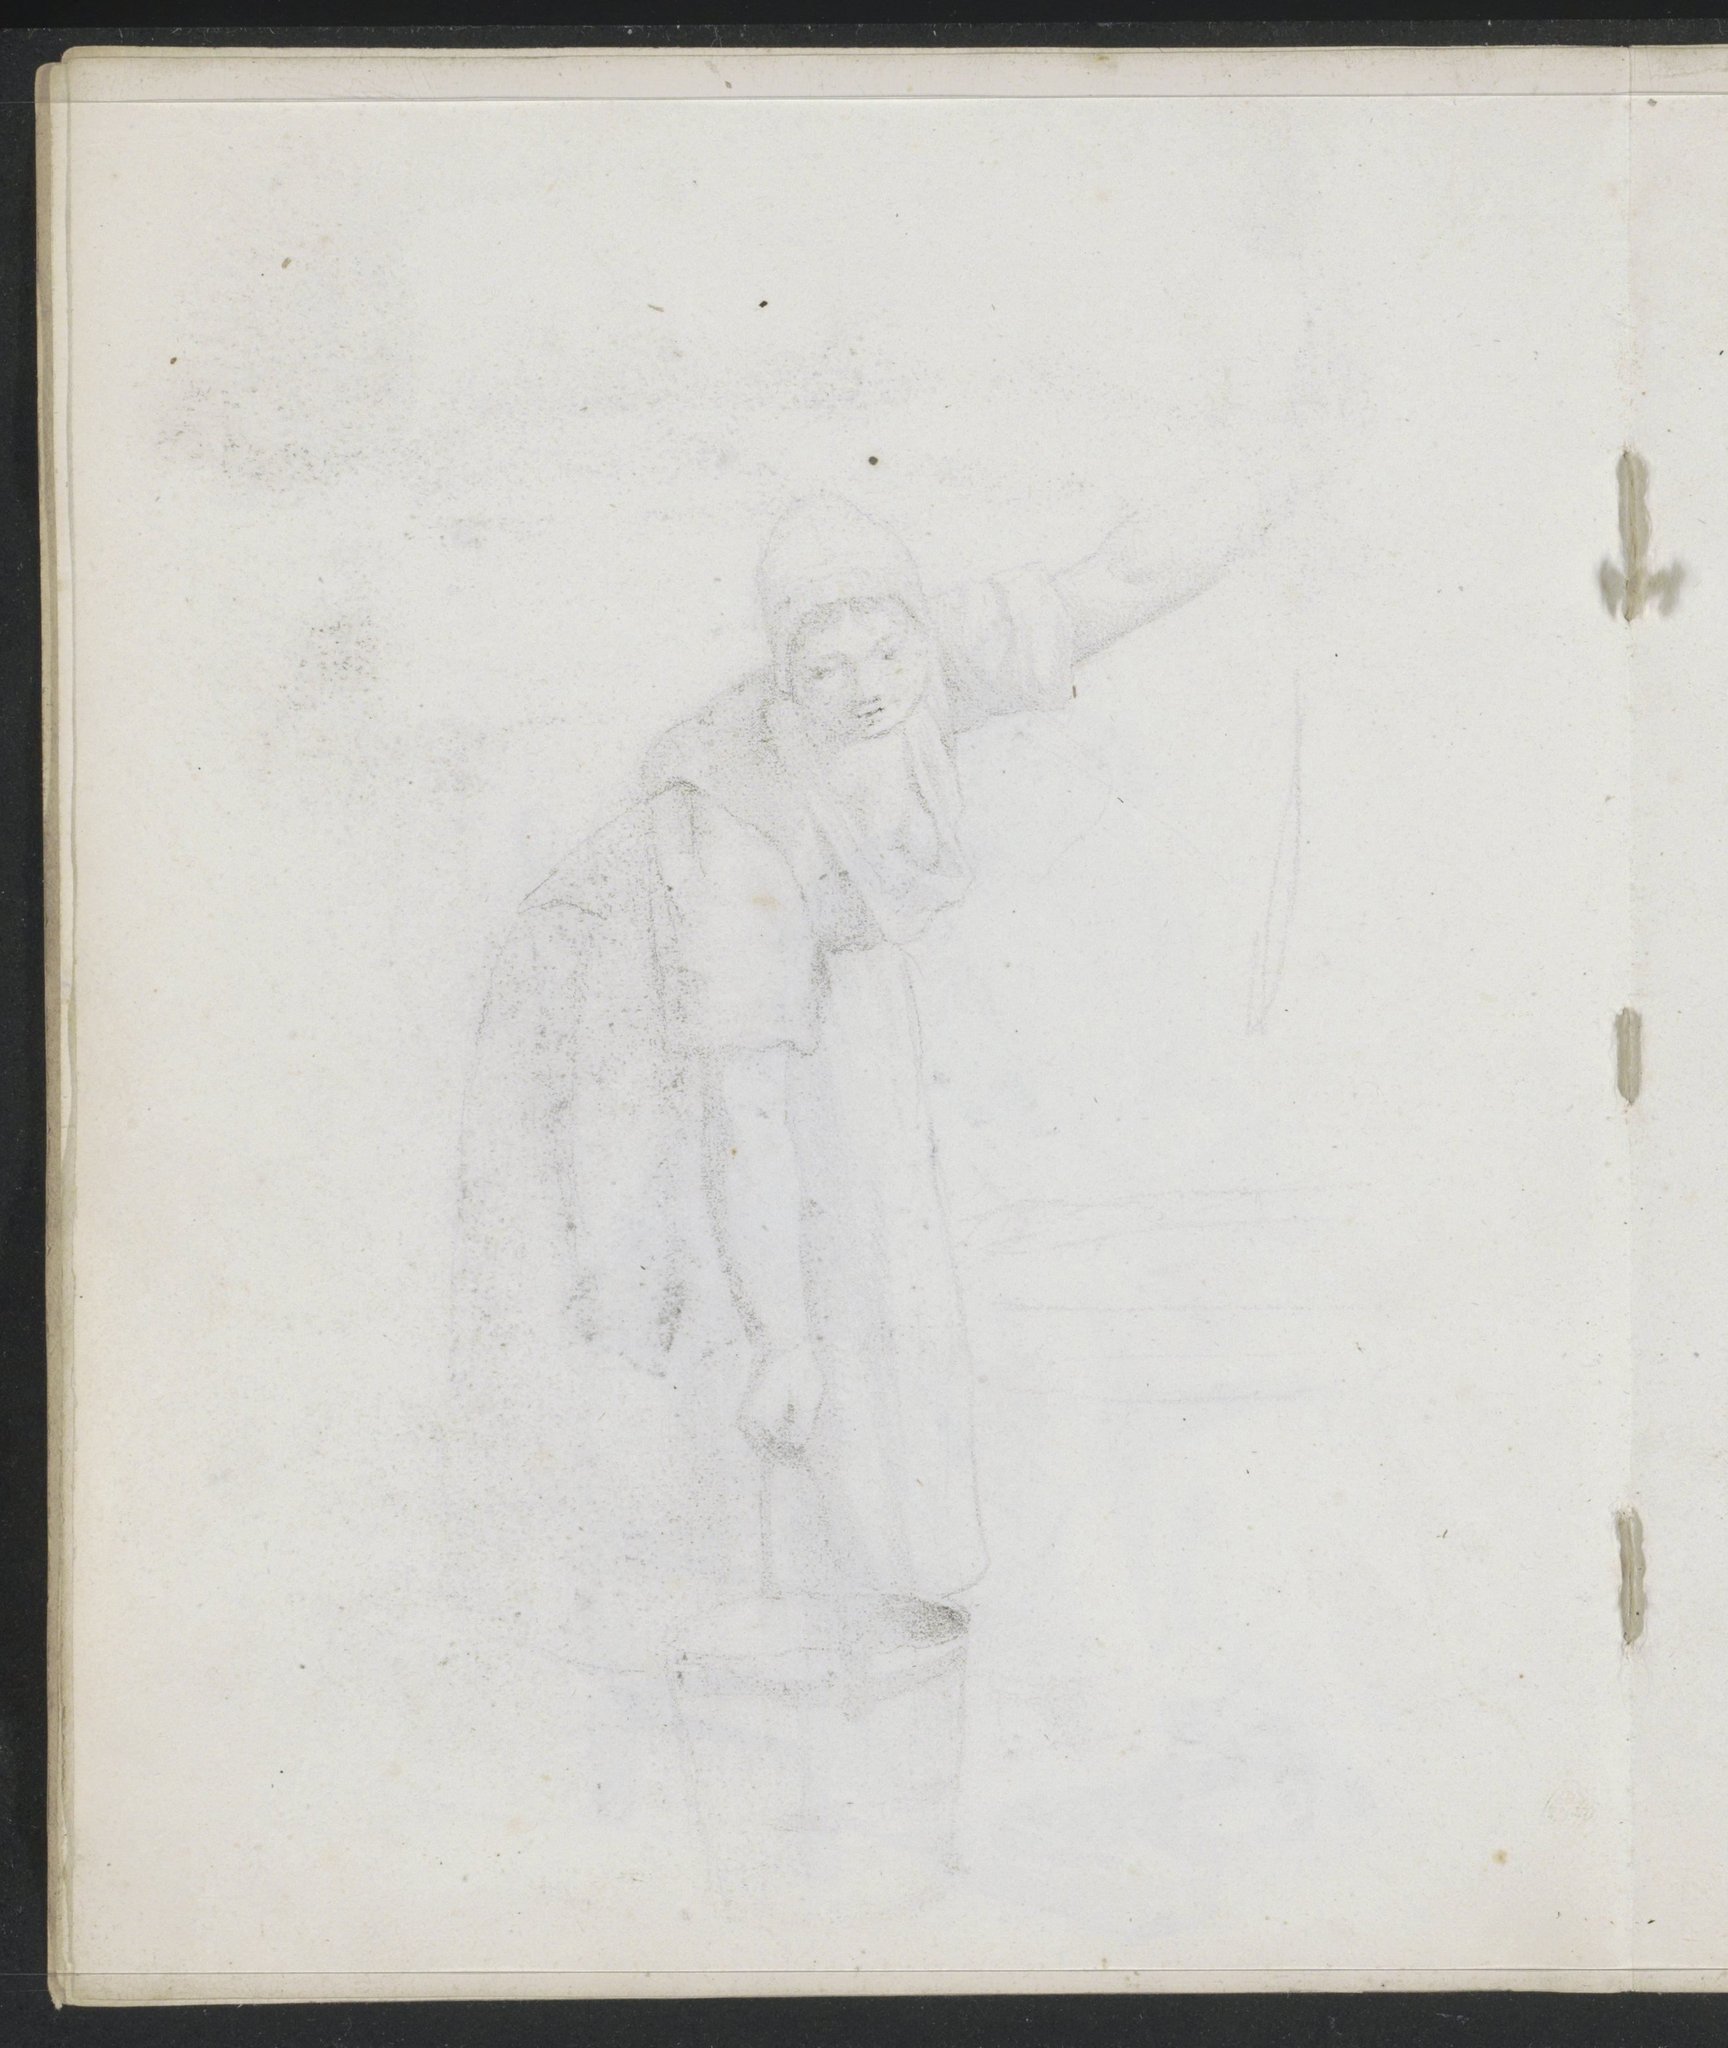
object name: sketchbook leaf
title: Boerin met een emmer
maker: balthasar paul ommeganck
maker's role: draughtsman, painter, print maker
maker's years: 1755-1826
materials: chalk, paper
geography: antwerp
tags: wooden container: barrel, cask, bucket, farmers - aa - female farmer, farmer's wife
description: De vrouw buigt voorover en tilt een houten emmer van de grond. Blad 3 verso uit een schetsboek met 8 bladen.